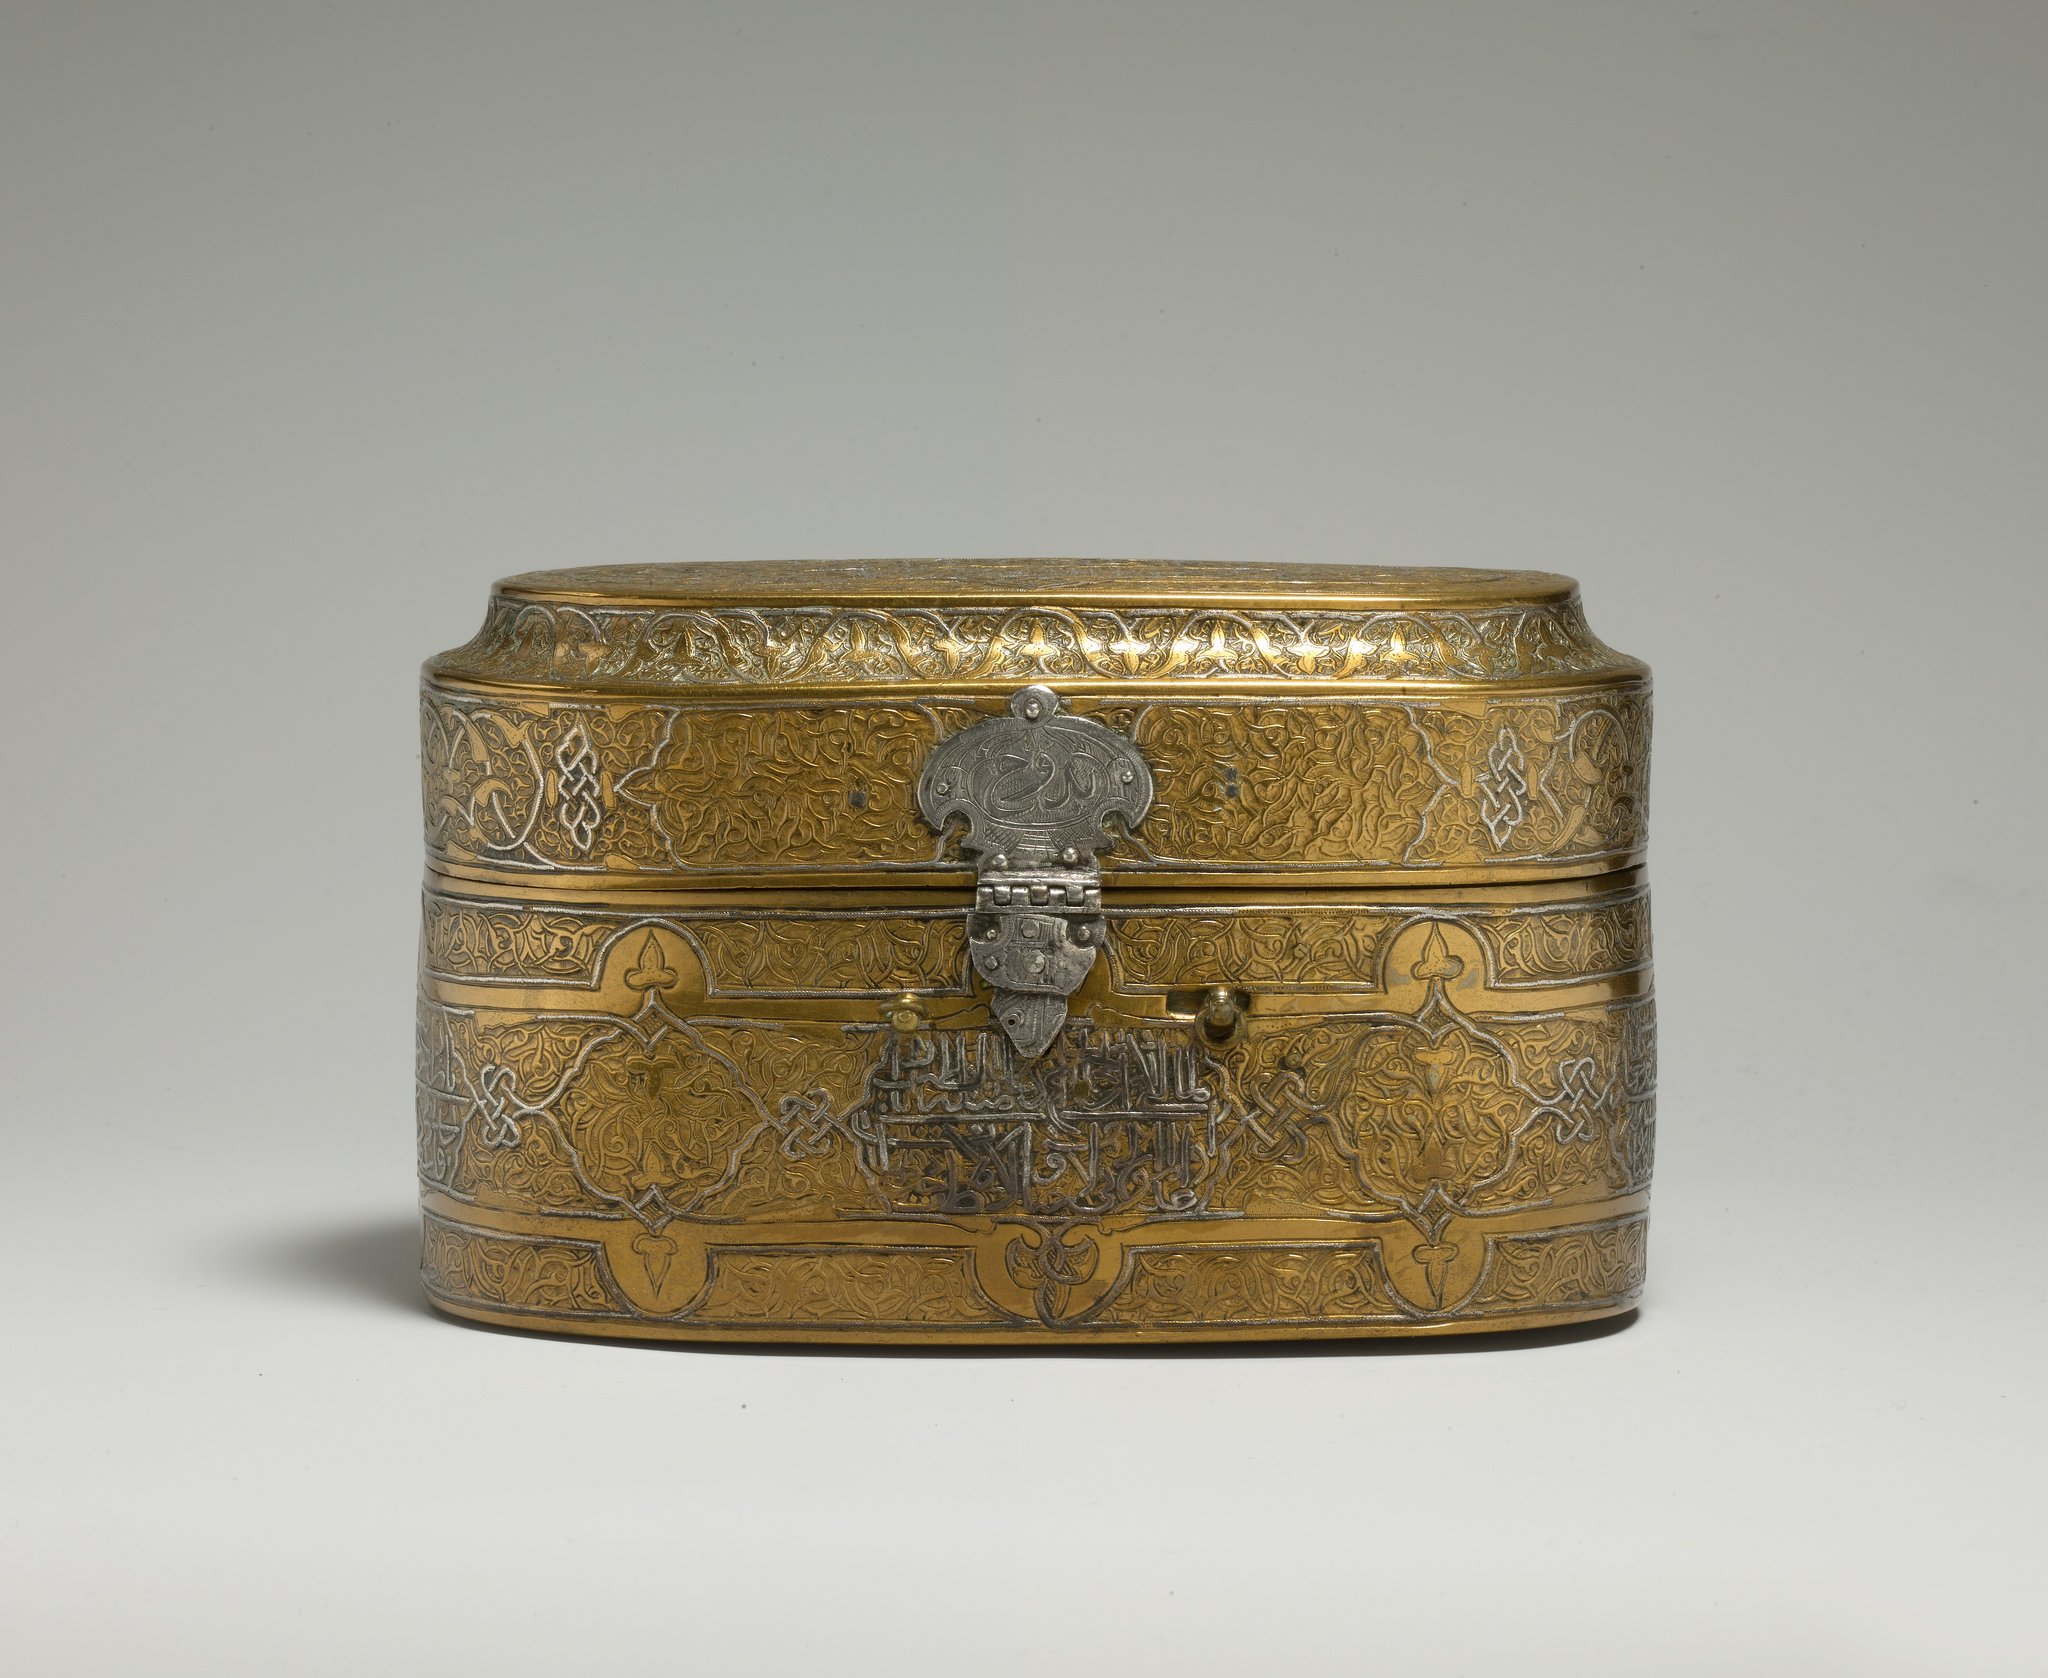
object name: box with lid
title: Lidded Box of Muhammad al-Hamawi, Timekeeper at the Umayyad Mosque, Damascus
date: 1401-1500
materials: brass, silver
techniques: engraving, inlay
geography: syria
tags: arabic